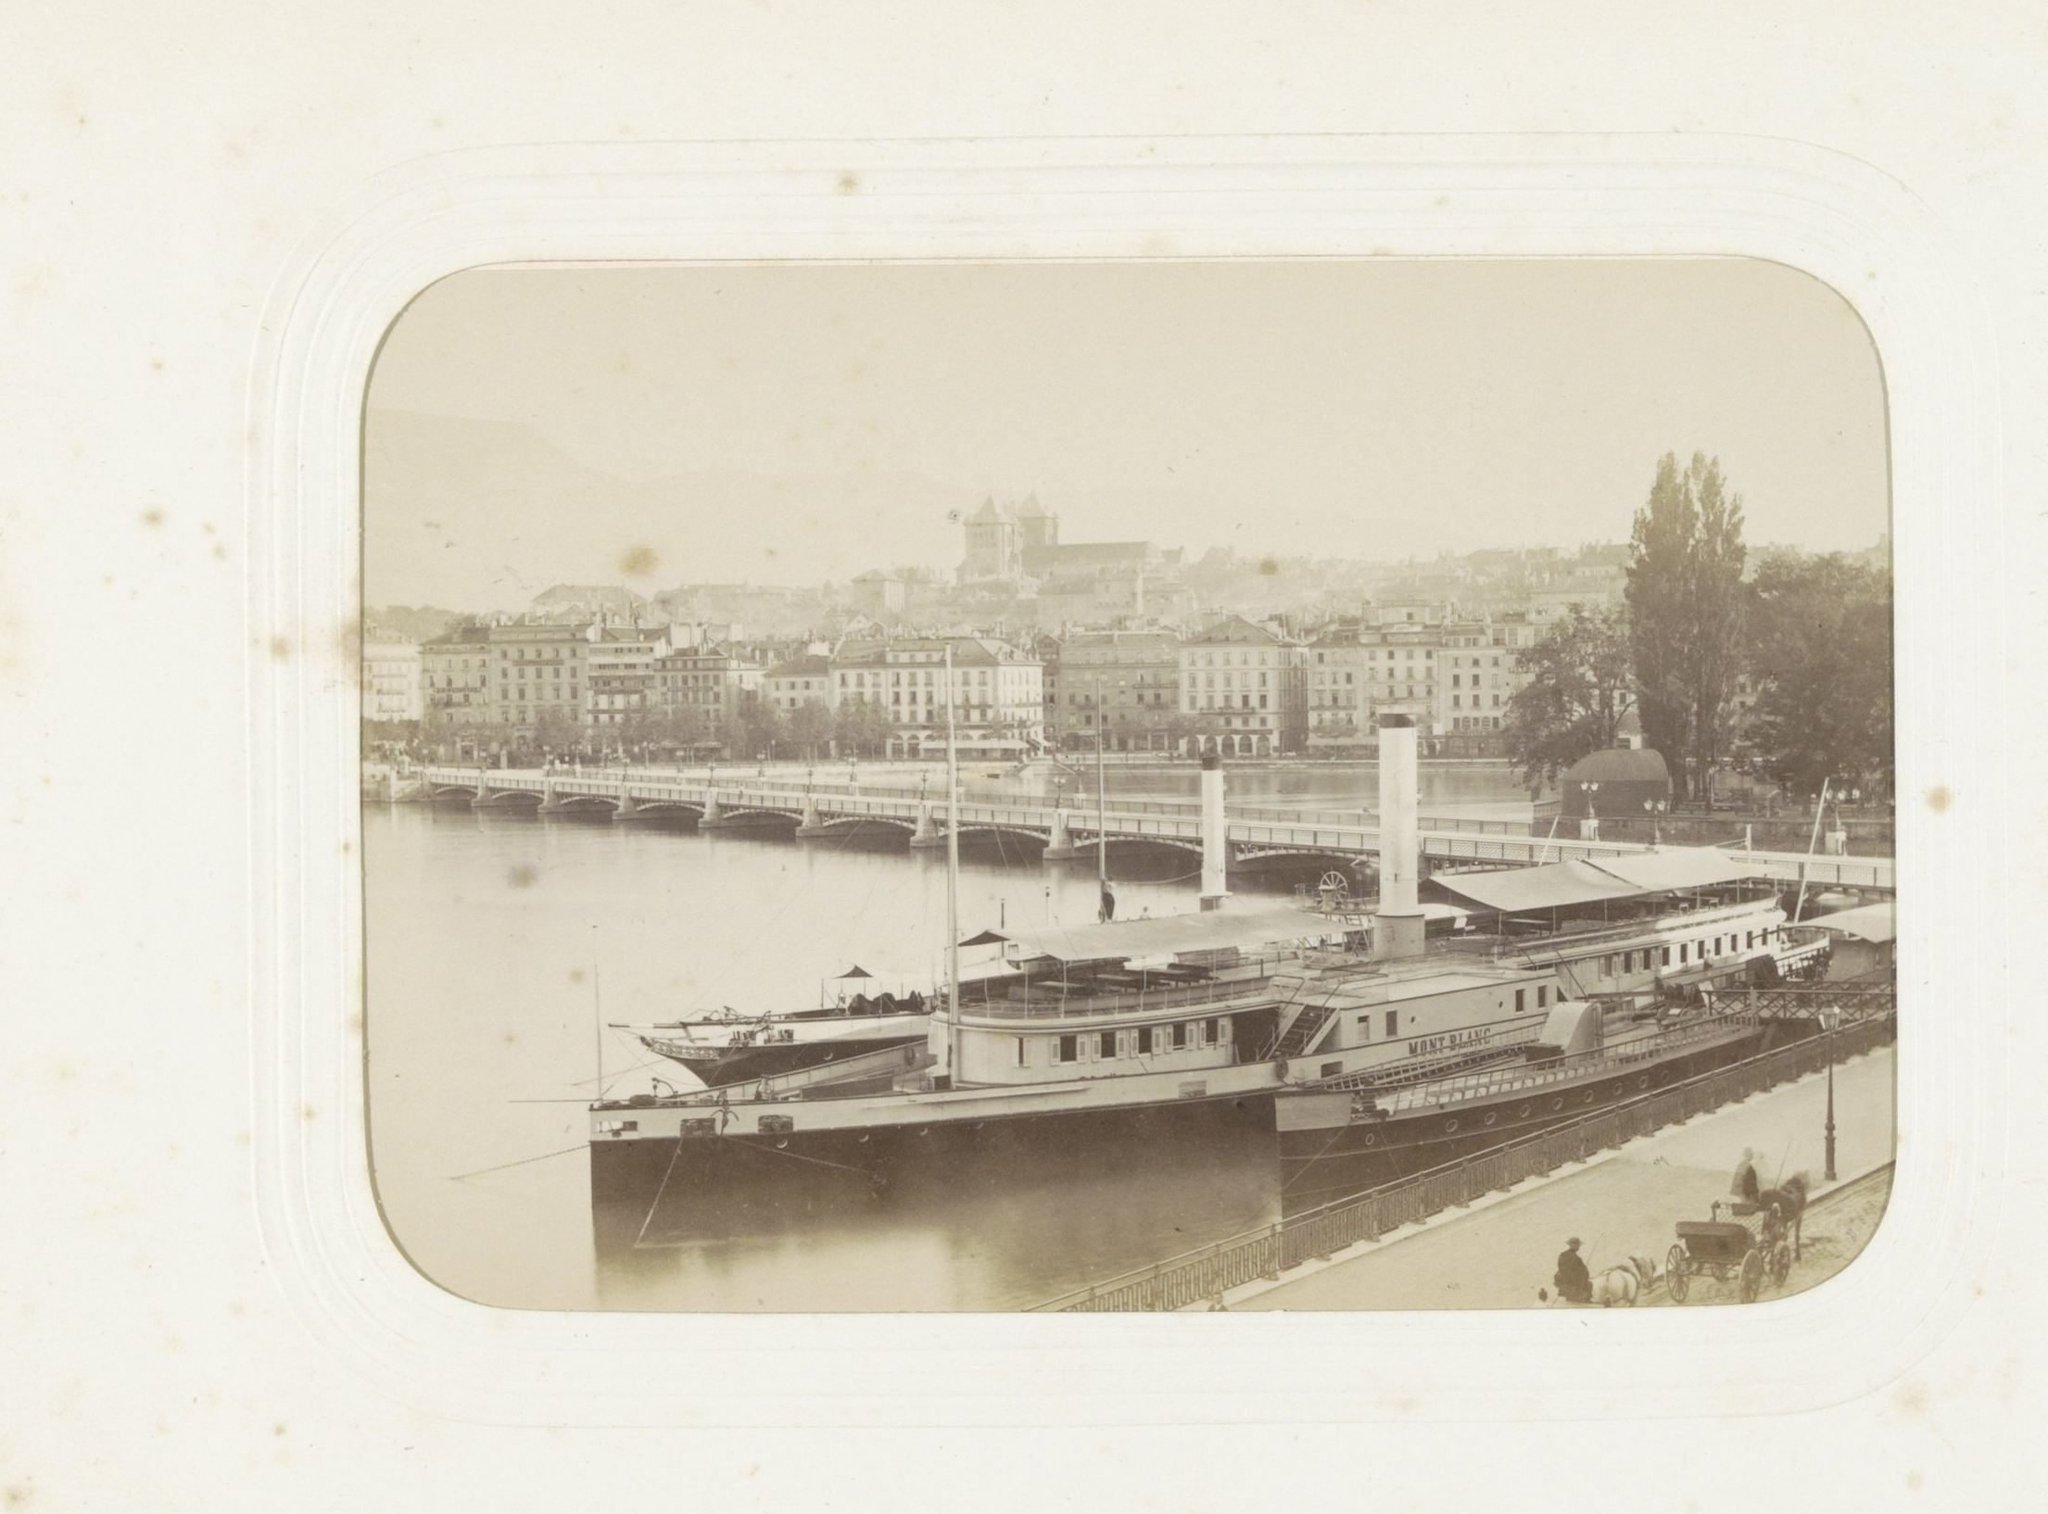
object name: album leaf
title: Genève gezien vanaf de Quai du Mont Blanc, met op de voorgrond aangemeerde schepen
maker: auguste garcin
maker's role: fotograaf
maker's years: 1816-1895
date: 1860-1880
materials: cardboard, paper, photographic support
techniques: albumen print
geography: geneva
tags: prospect of city, town panorama, silhouette of city, steamship, motorship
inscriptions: number: ‘18’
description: Onderdeel van Reisalbum met bezienswaardigheden in de Zwitserse Alpen.